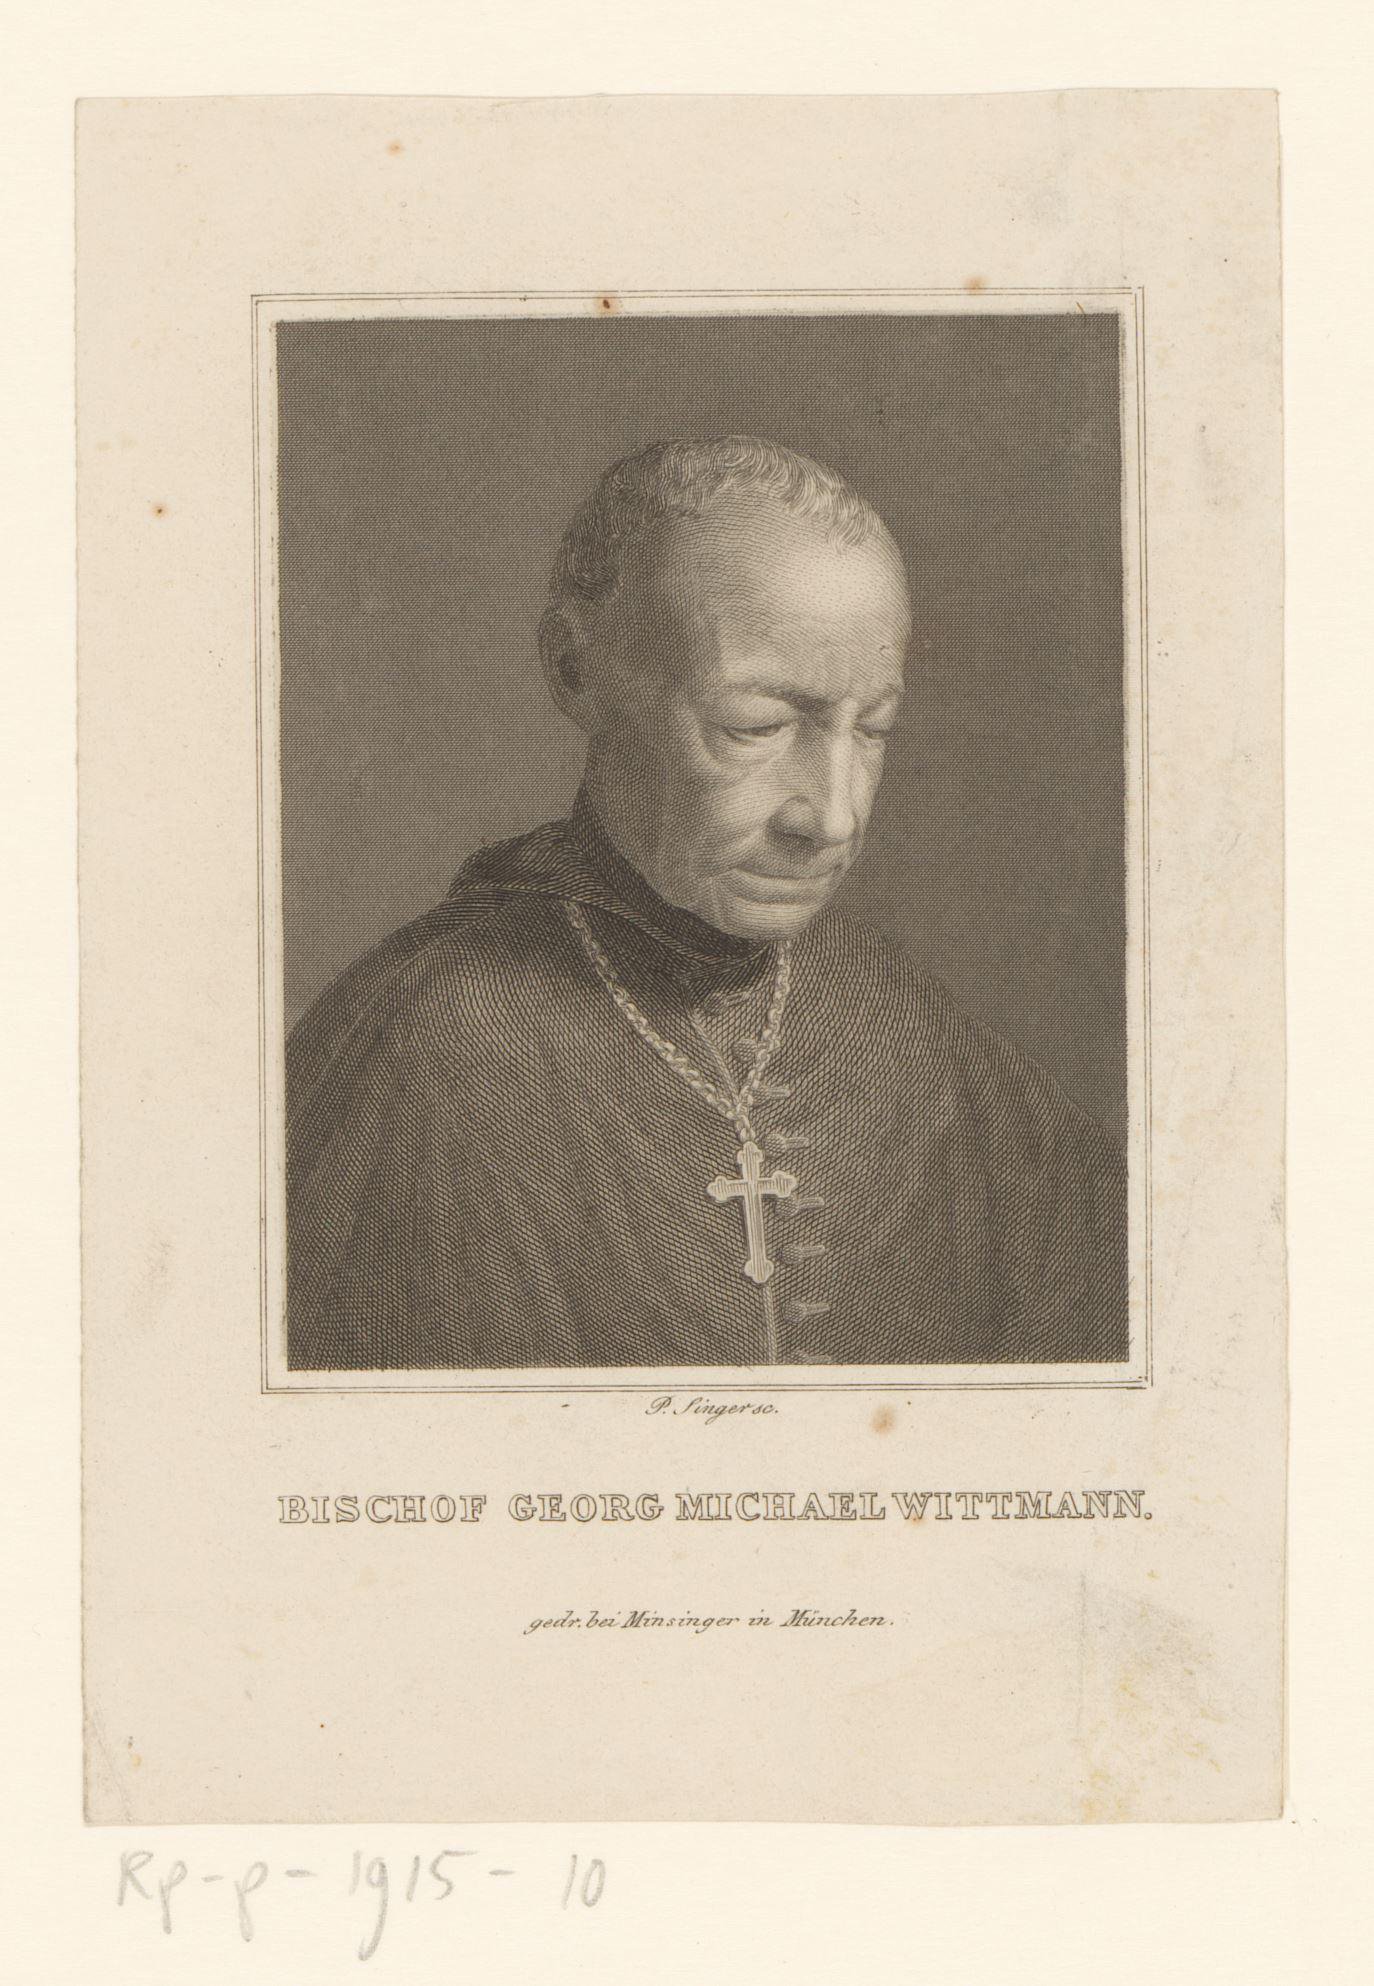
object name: print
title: Portret van Georg Michael Wittmann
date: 1800-1899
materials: paper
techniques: engraving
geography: munich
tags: liturgical vestments, canonicals, theologian, historical persons, crucifix ~ personal devotion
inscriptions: collector's mark: Lugt 2228